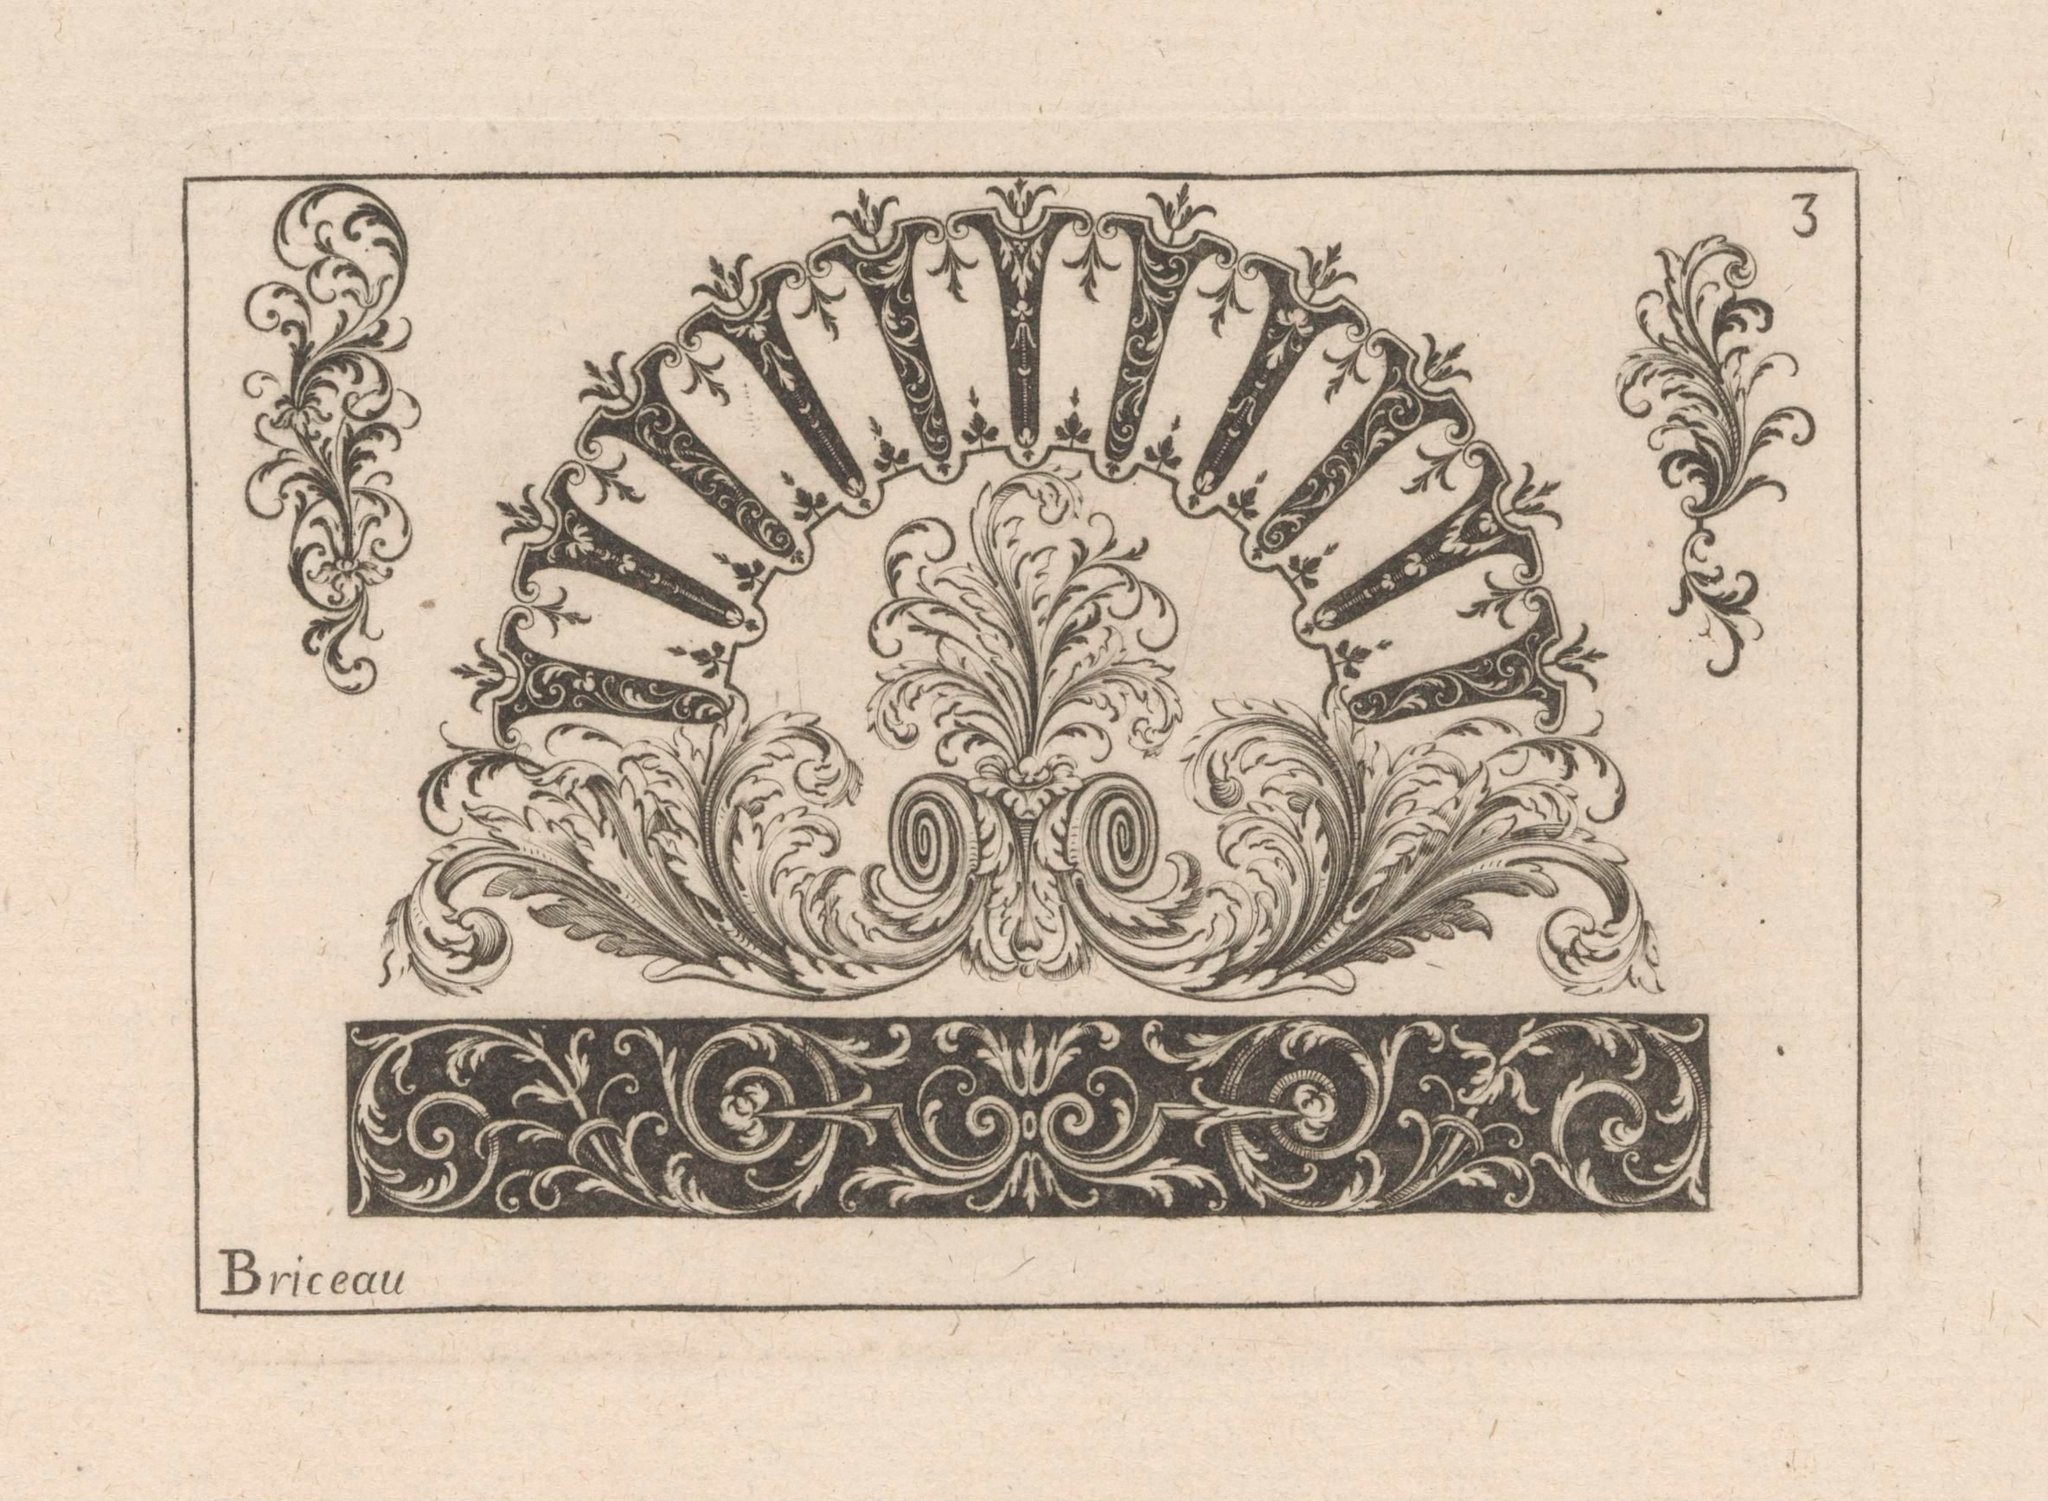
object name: ornament print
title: Boogvormig ornament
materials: paper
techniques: etching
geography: paris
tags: ornaments ~ art, interlace ~ ornament, ornament derived from plant forms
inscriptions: collector's mark: Lugt 2228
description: Een boogvormig ornament met daaronder bladmotieven en een rechthoek gevuld met vlechtwerk.